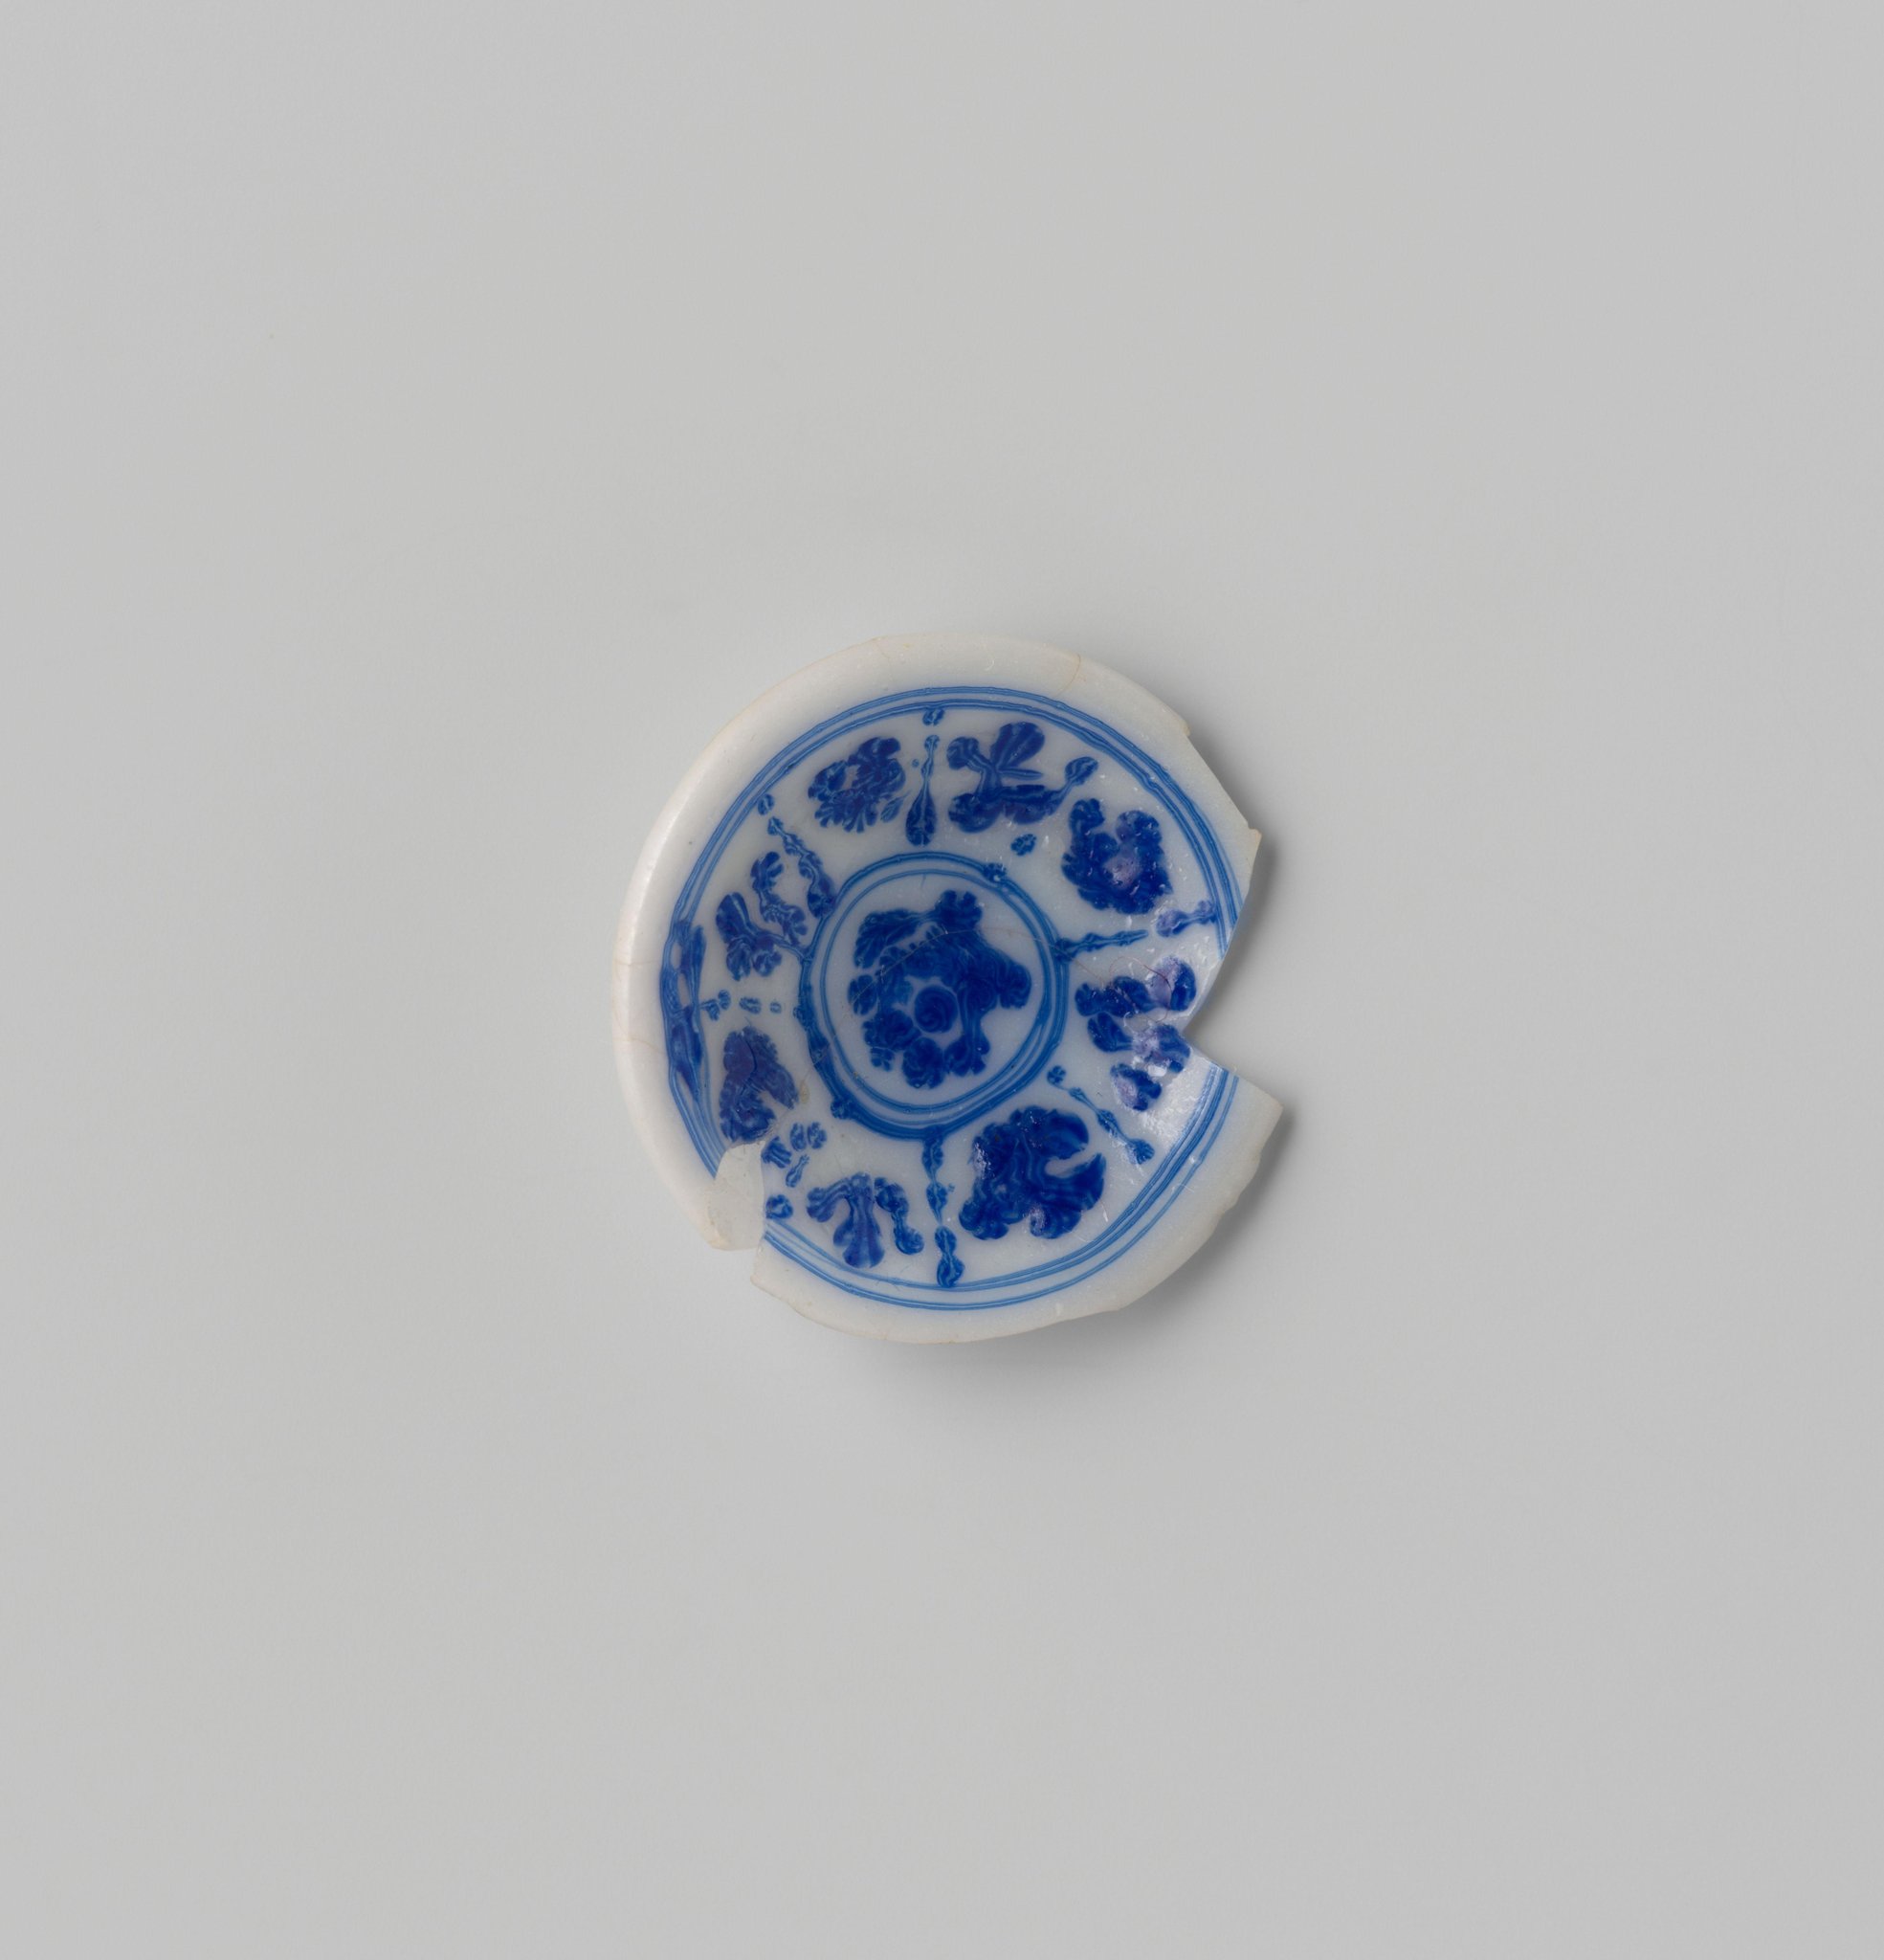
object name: platter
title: Schotel van melkglas met blauwe emailverf beschildering, imitatie Chinees porselein; bloemmotieven in vakken in Kraakporselein stijl; dubbelwandig met gladde rand.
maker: Anonymous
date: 1675-1710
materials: glass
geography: amsterdam